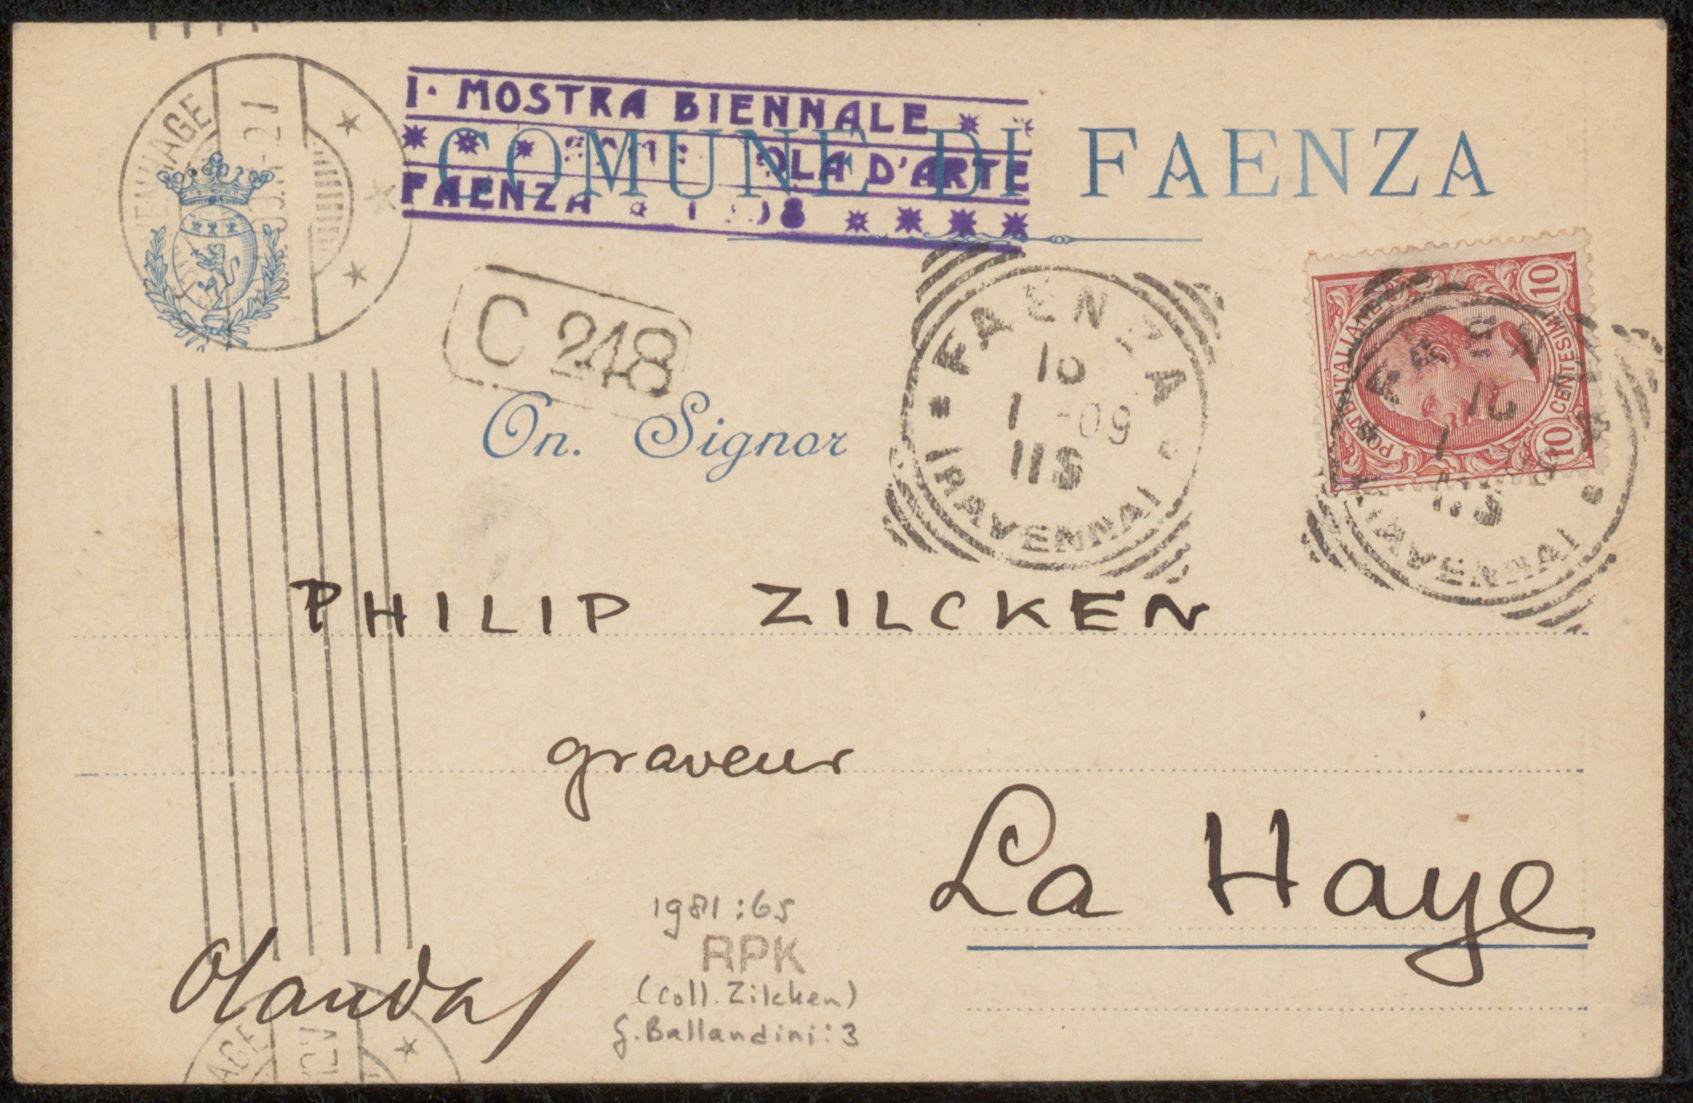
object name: postcard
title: Briefkaart aan Philip Zilcken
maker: gaetano ballardini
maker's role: kunsthistoricus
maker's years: 1878-1953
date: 1909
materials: cardboard, ink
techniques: pen, writing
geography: faenza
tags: the hague, painter, draughtsman, philip zilcken, temporary exhibition, 'salon', printed matter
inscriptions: collector's mark: ‘RPK’